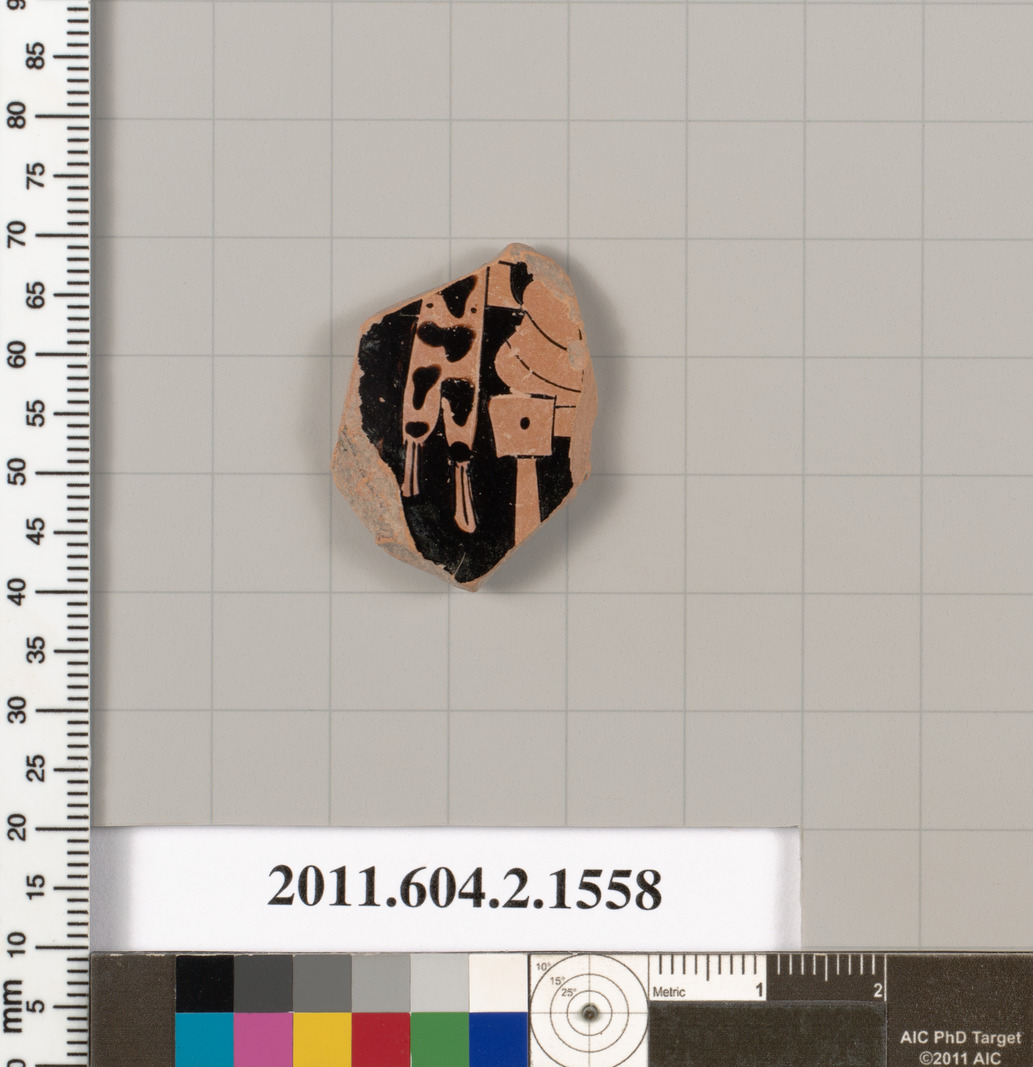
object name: skyphos fragment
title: Terracotta fragment of a skyphos (deep drinking cup)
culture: greek, attic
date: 490-470 BCE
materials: terracotta